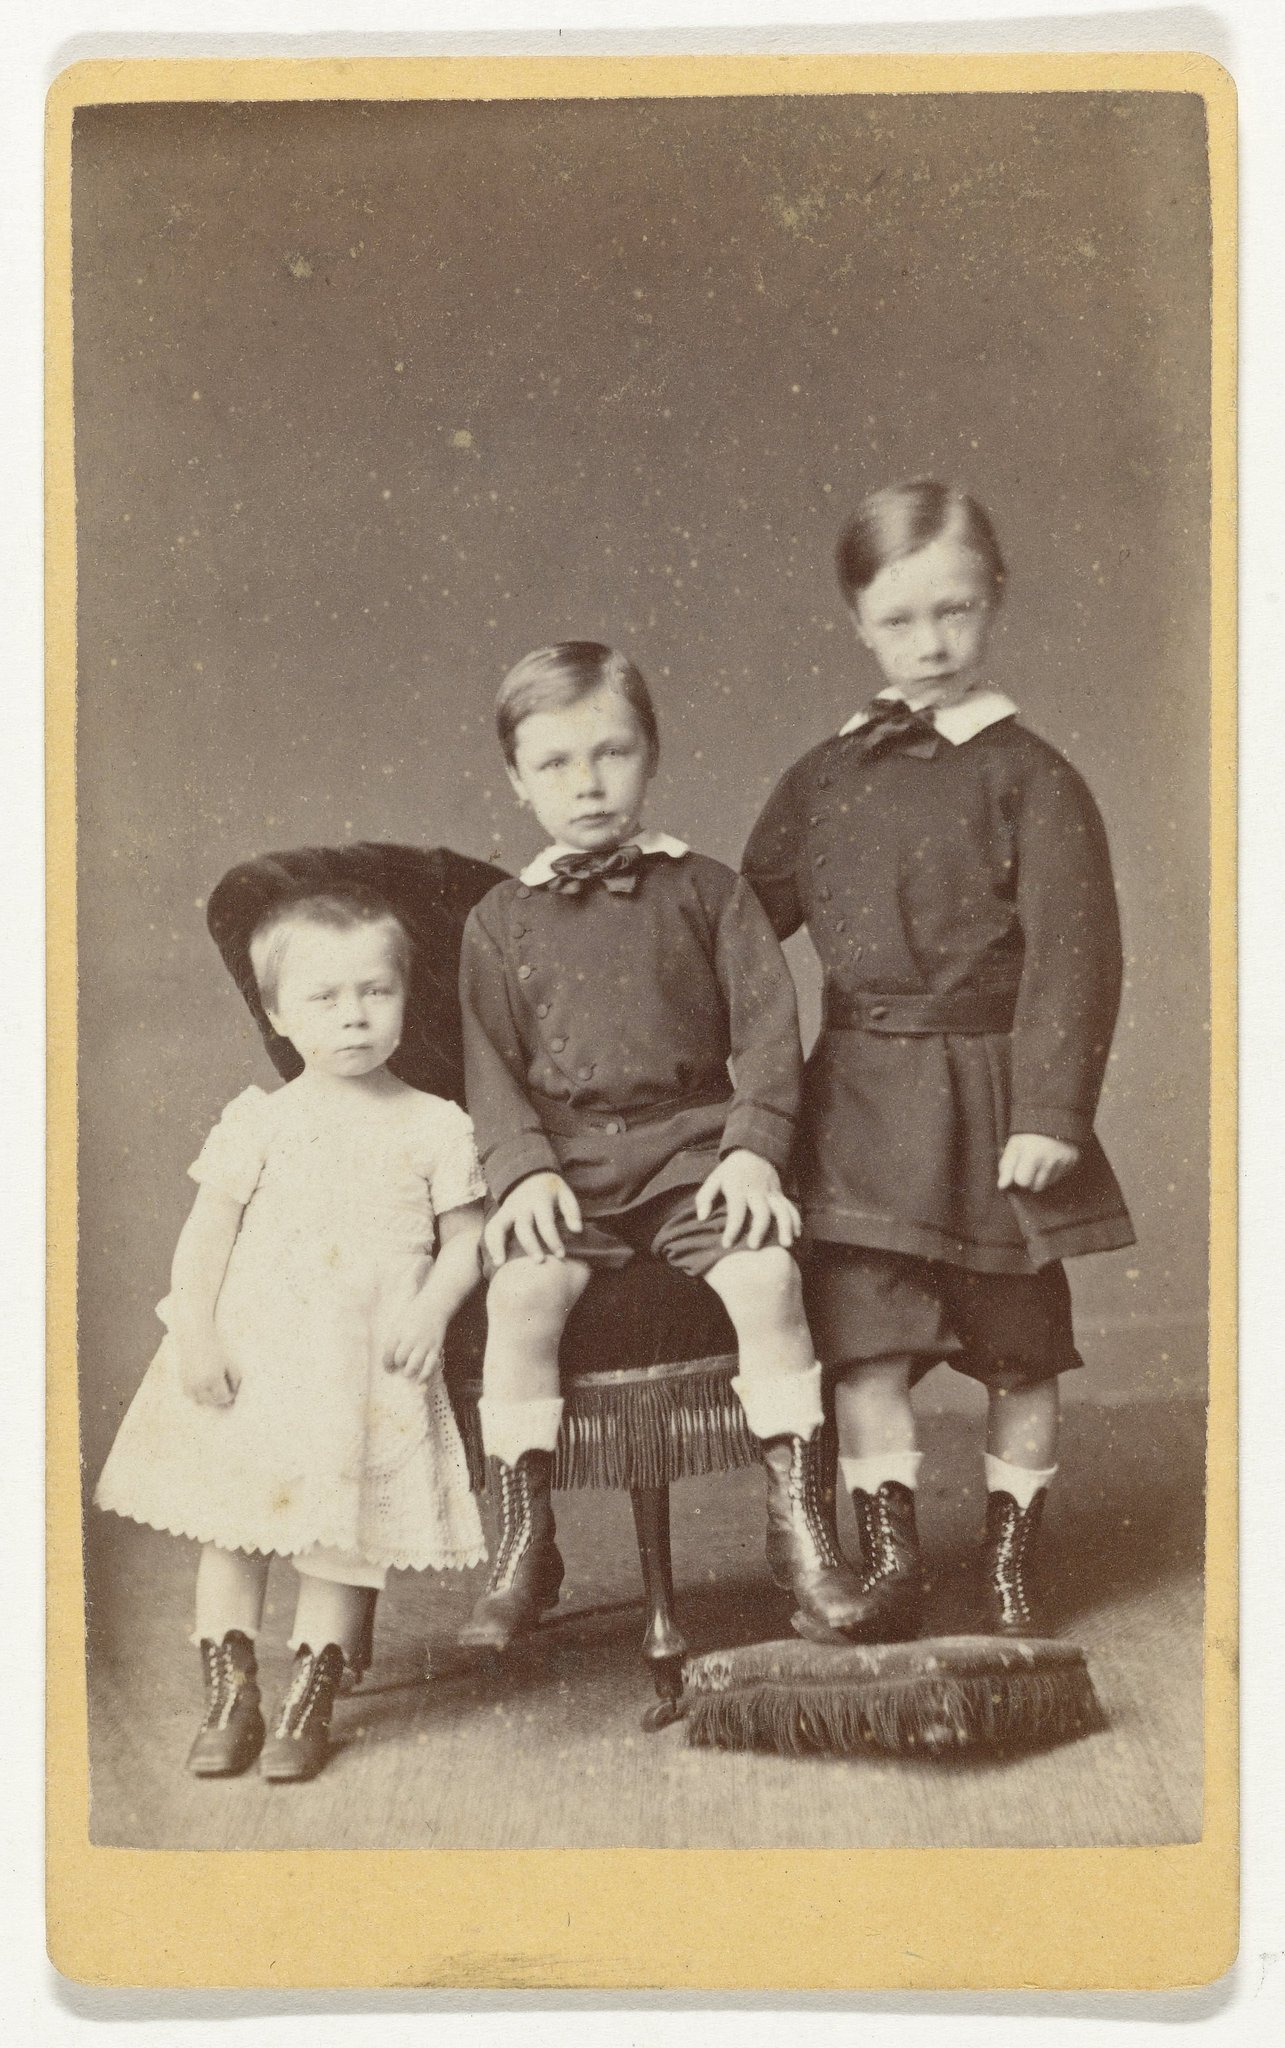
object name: carte de visite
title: Portret van drie kinderen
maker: christiaan martinus jan hermelink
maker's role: fotograaf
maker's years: 1840-1933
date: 1872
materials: cardboard, paper, photographic support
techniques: albumen print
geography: the hague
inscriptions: signature and address: ‘Hermelink/62 Dennenweg 62/'s Hage’, number: ‘No 21990 Bij nabestellingen dit nummer optegeven.’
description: Twee jongens en een klein kind in een wit jurkje, staand bij of zittend op een stoel met een voetenbankje ervoor.